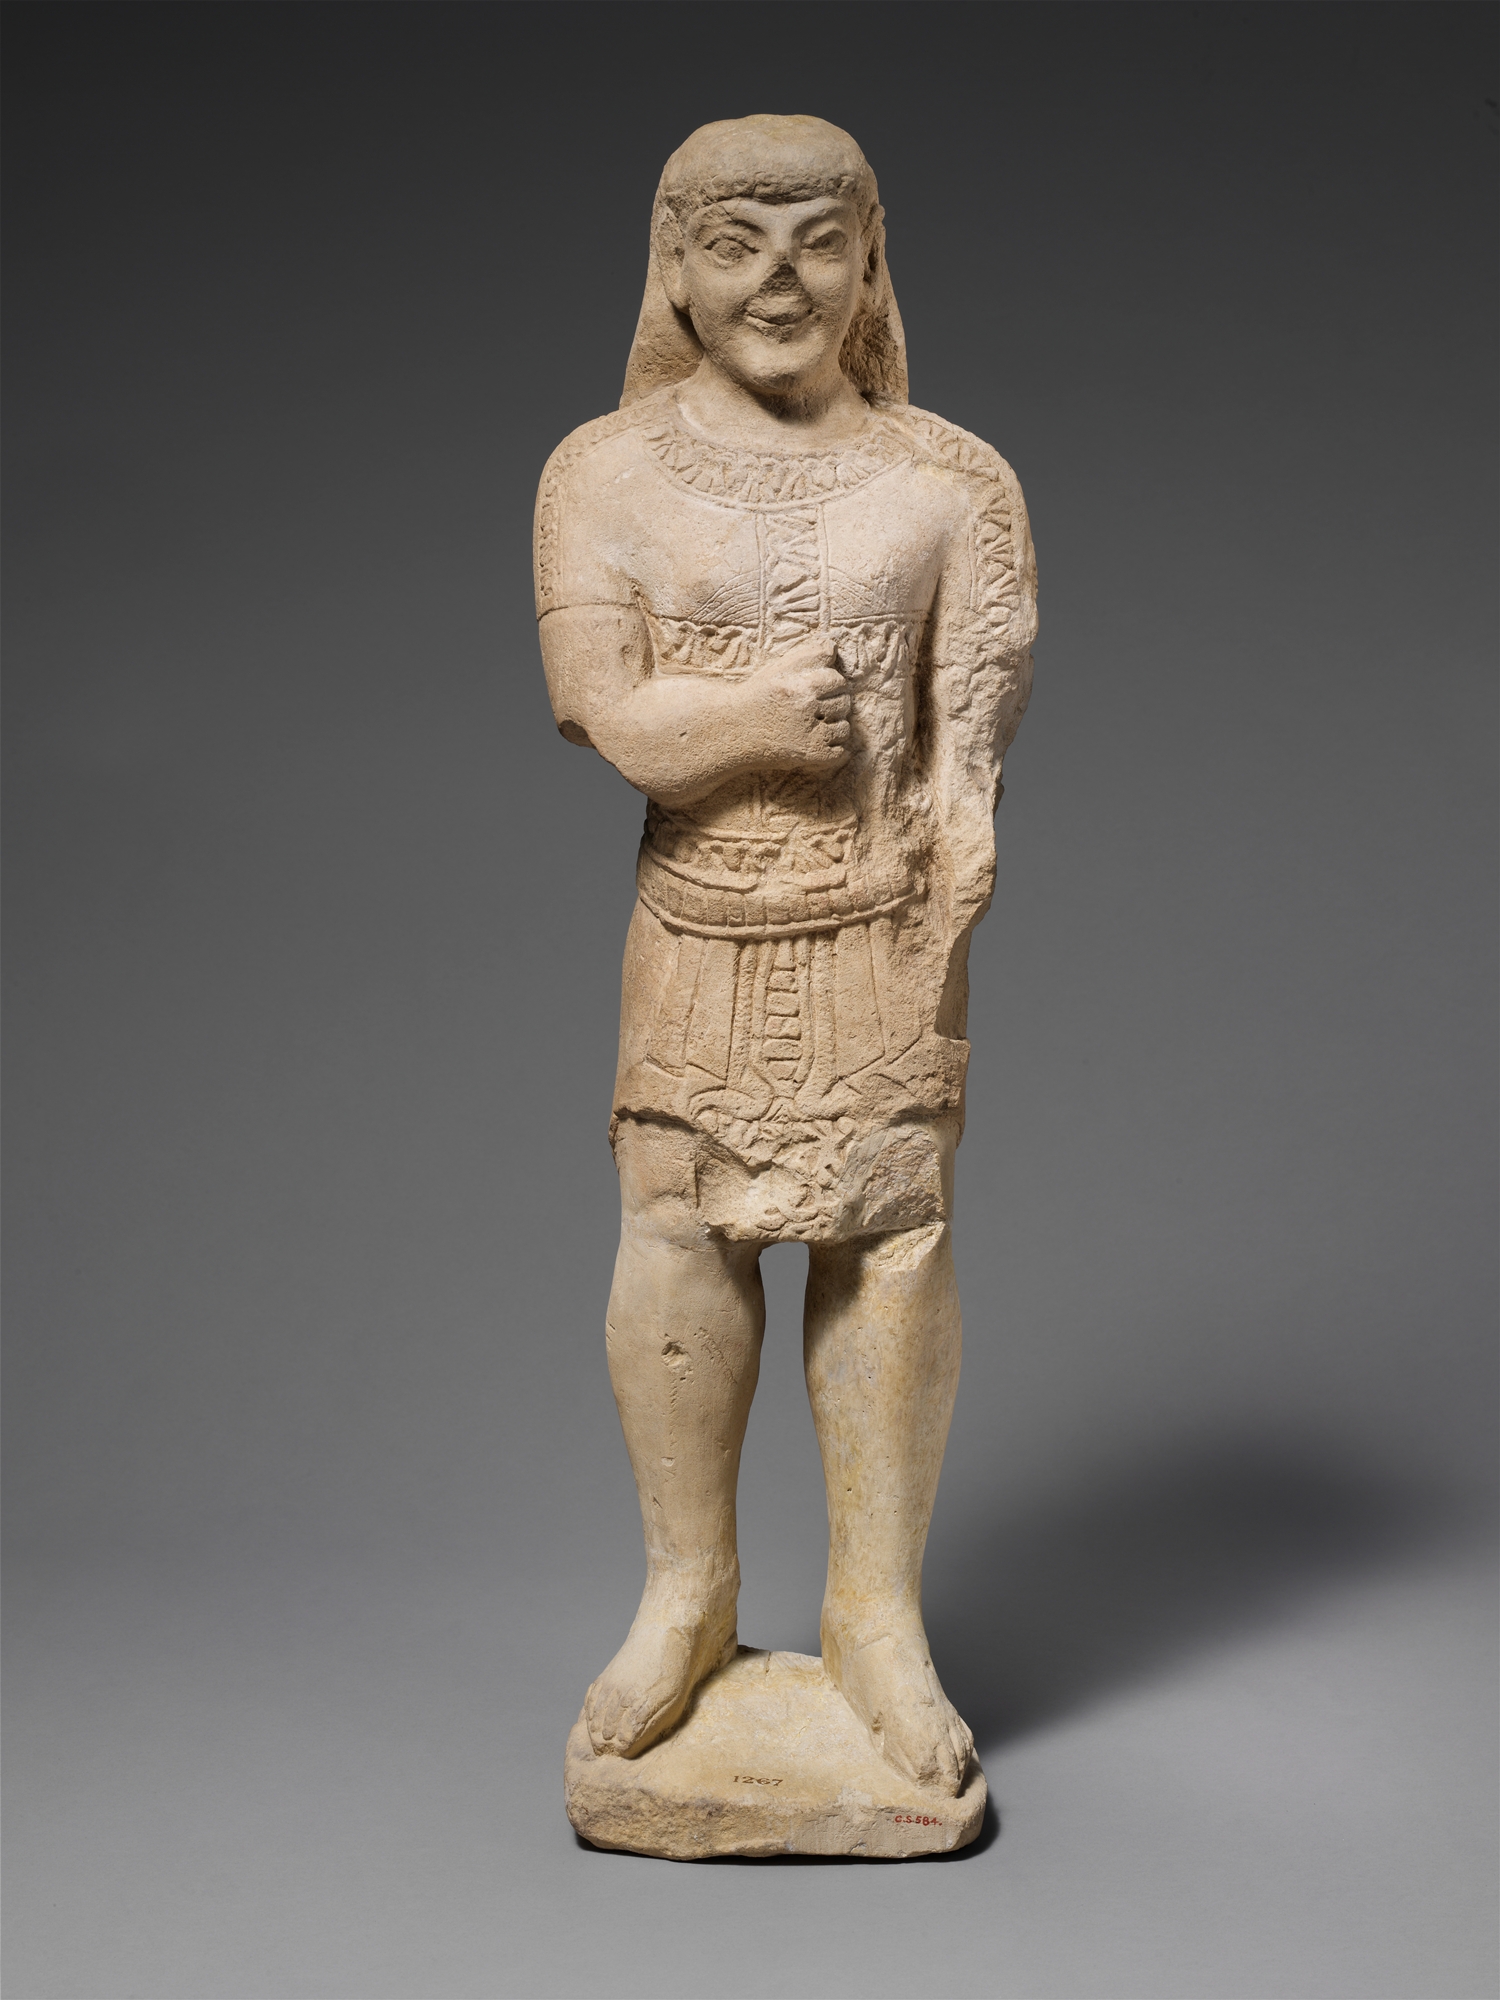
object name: statue of a votary, male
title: Limestone statuette of a beardless male votary in Egyptianizing dress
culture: cypriot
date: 567-535 BCE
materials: limestone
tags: men